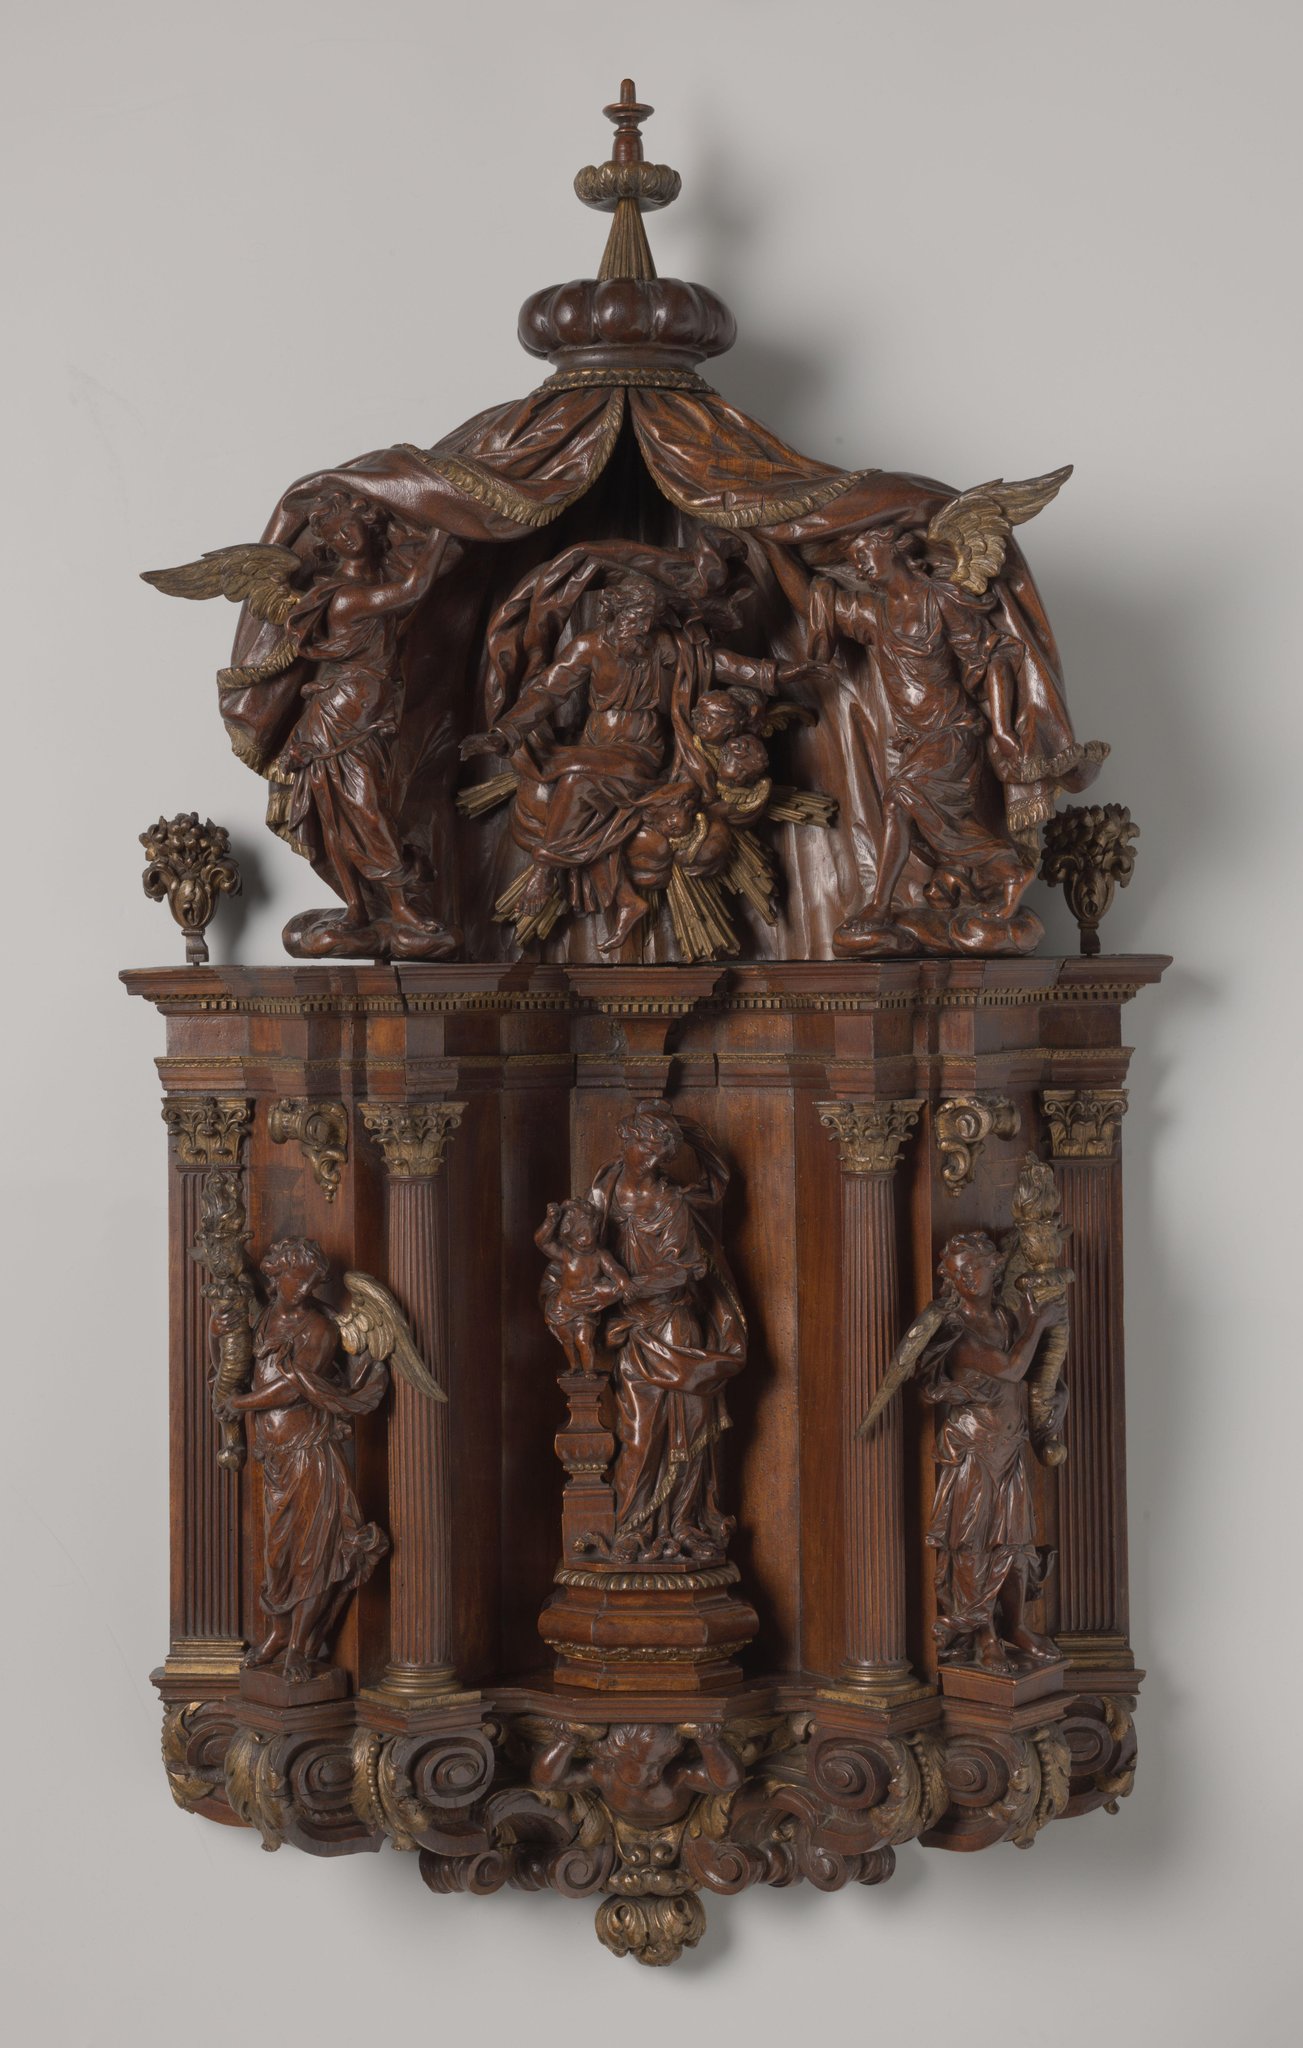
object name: altar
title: Onderdelen van devotie-altaar met Maria en Christuskind tussen twee engelen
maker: Anonymous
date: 1700-1750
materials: wood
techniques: gilding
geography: southern netherlands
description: Huisaltaar met Maria en Christuskind tussen twee engelen. Het Christuskind staat op een hoge sokkel. Boven Maria en het Kind zit God geflankeerd door twee engelen die een baldakijn boven Hem ophouden. Op verschillende plaatsen is het hout verguld.